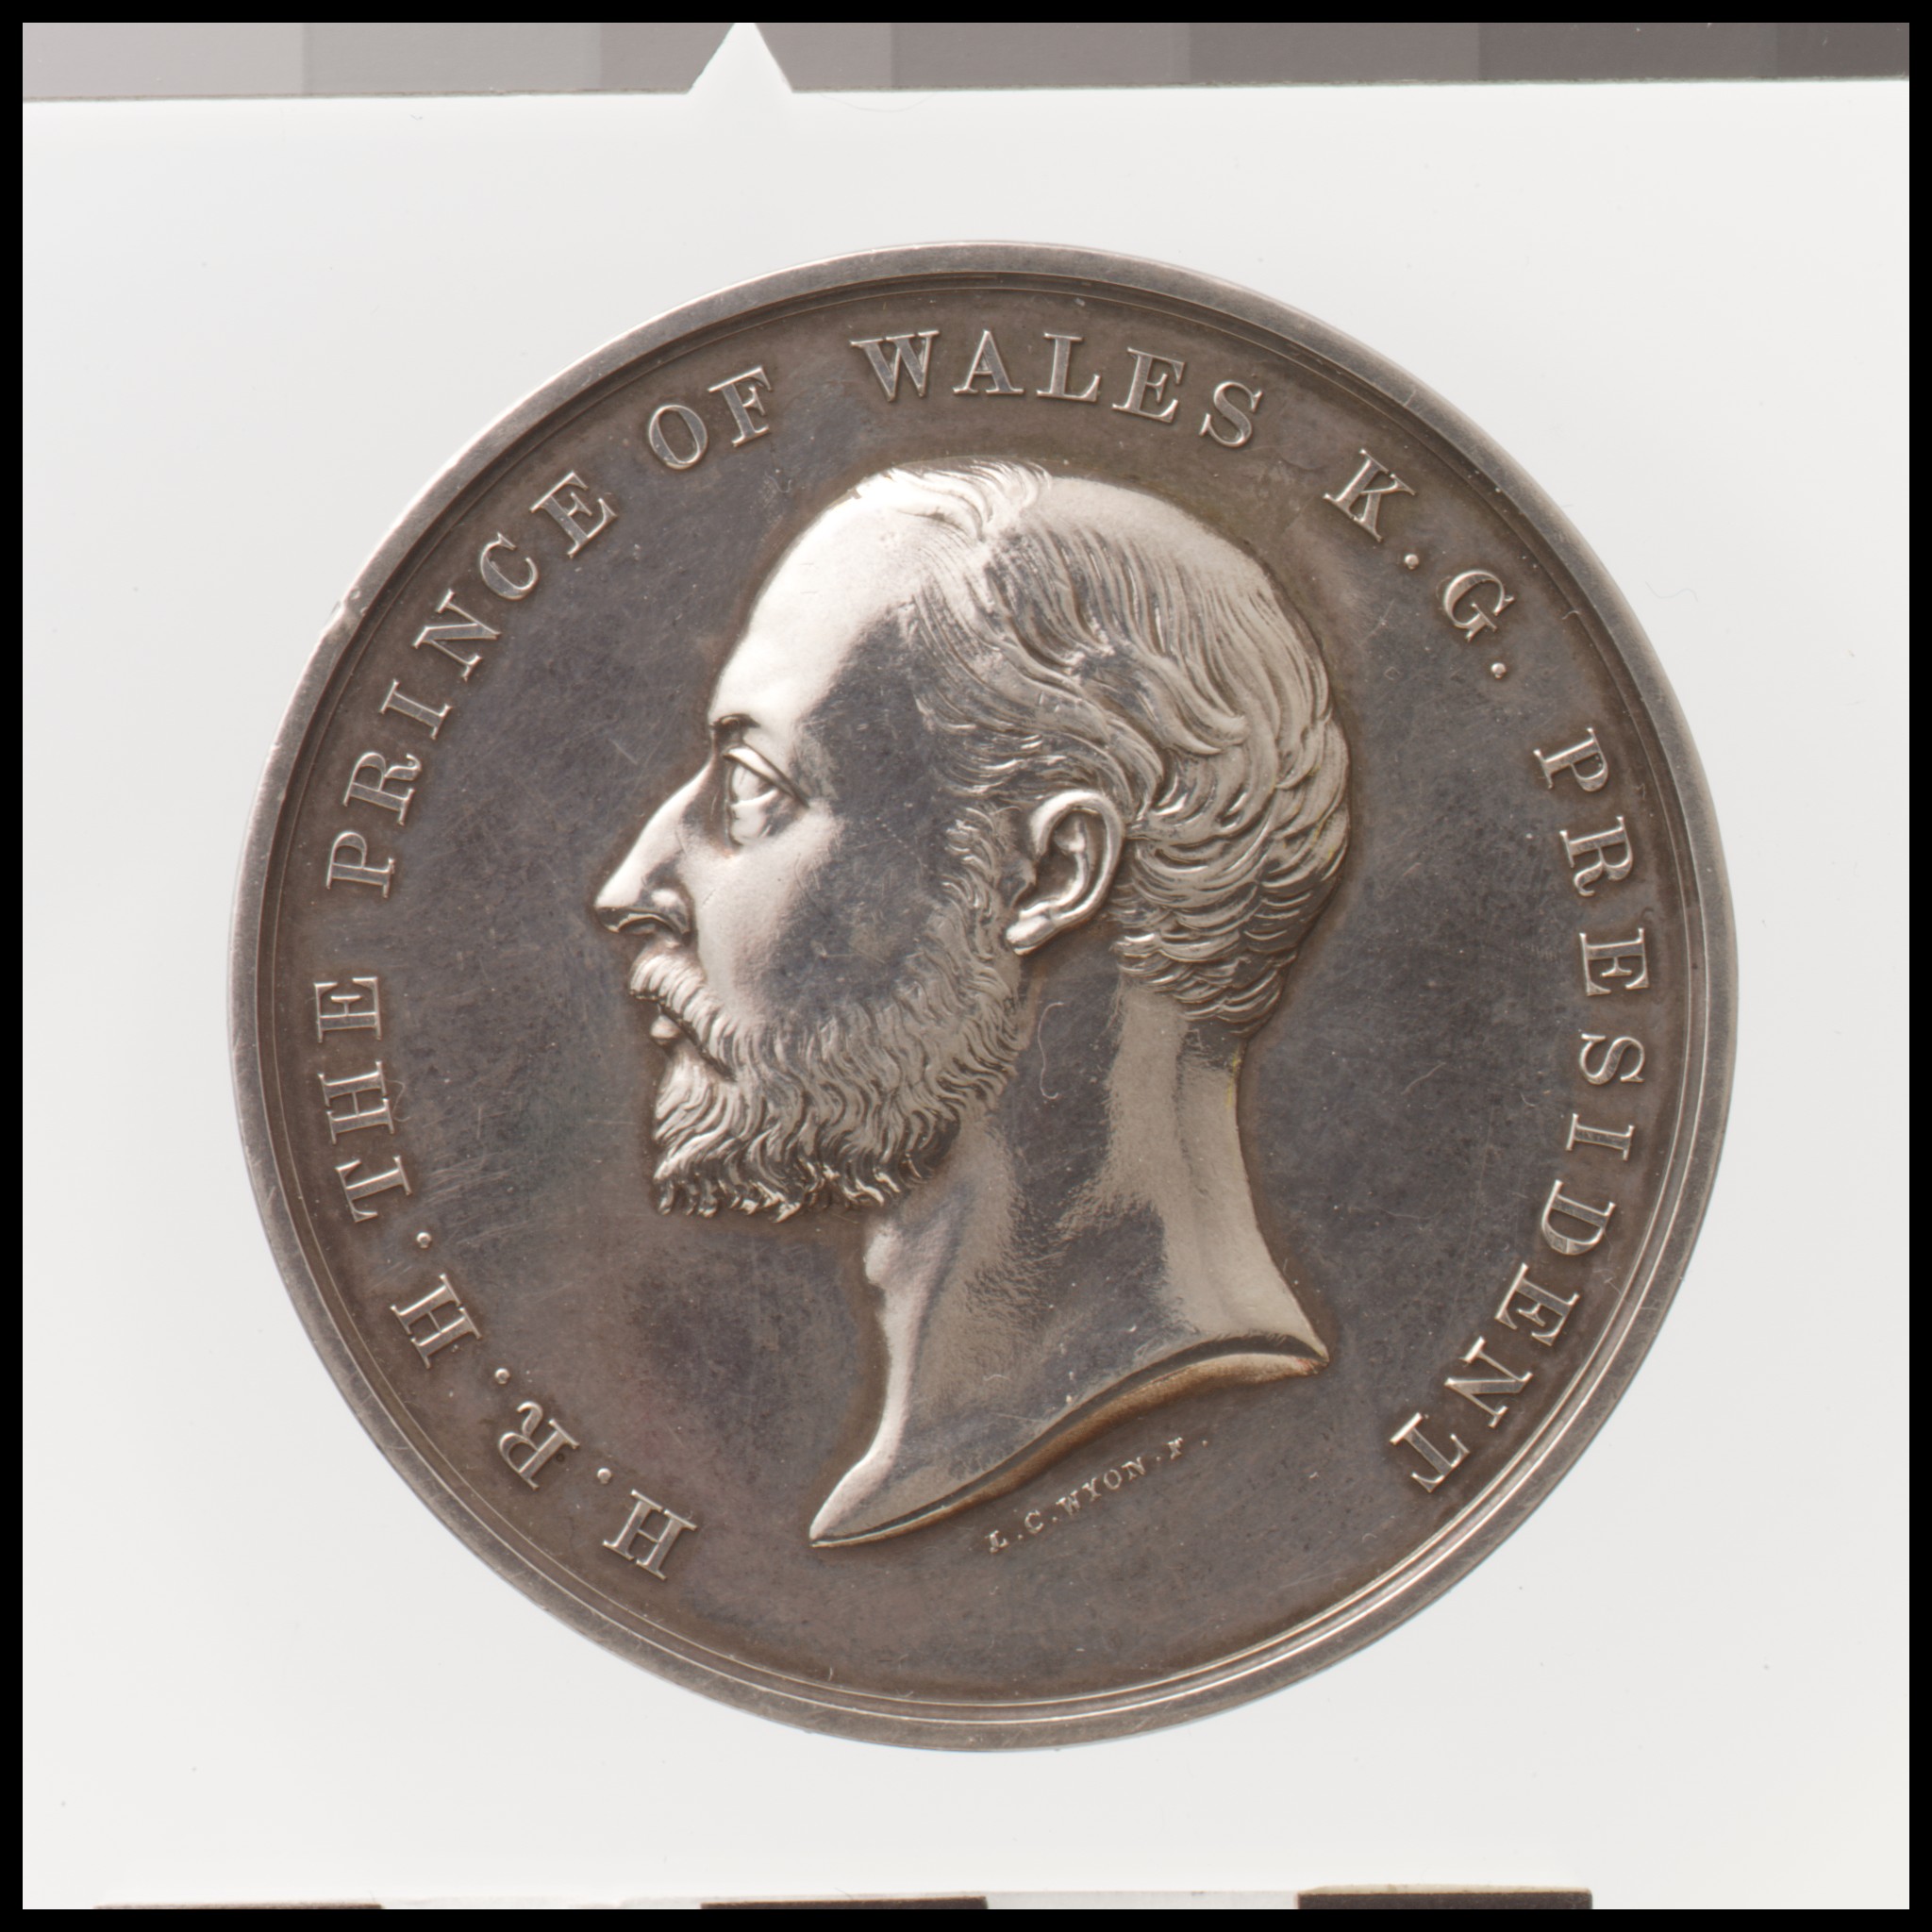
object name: medal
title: Prince Albert Technological Exam Medal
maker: leonard charles wyon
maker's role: artist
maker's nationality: british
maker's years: 1826-1891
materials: silver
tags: princes,profiles,coat of arms